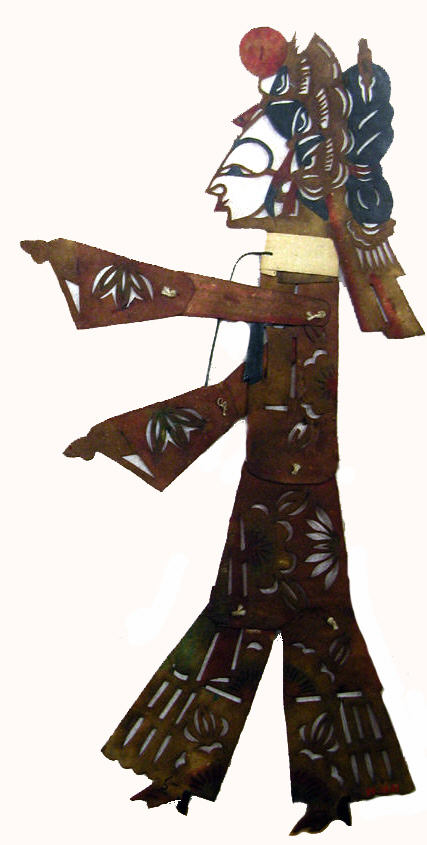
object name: shadow player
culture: chinese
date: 1801-1900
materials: cord, skin